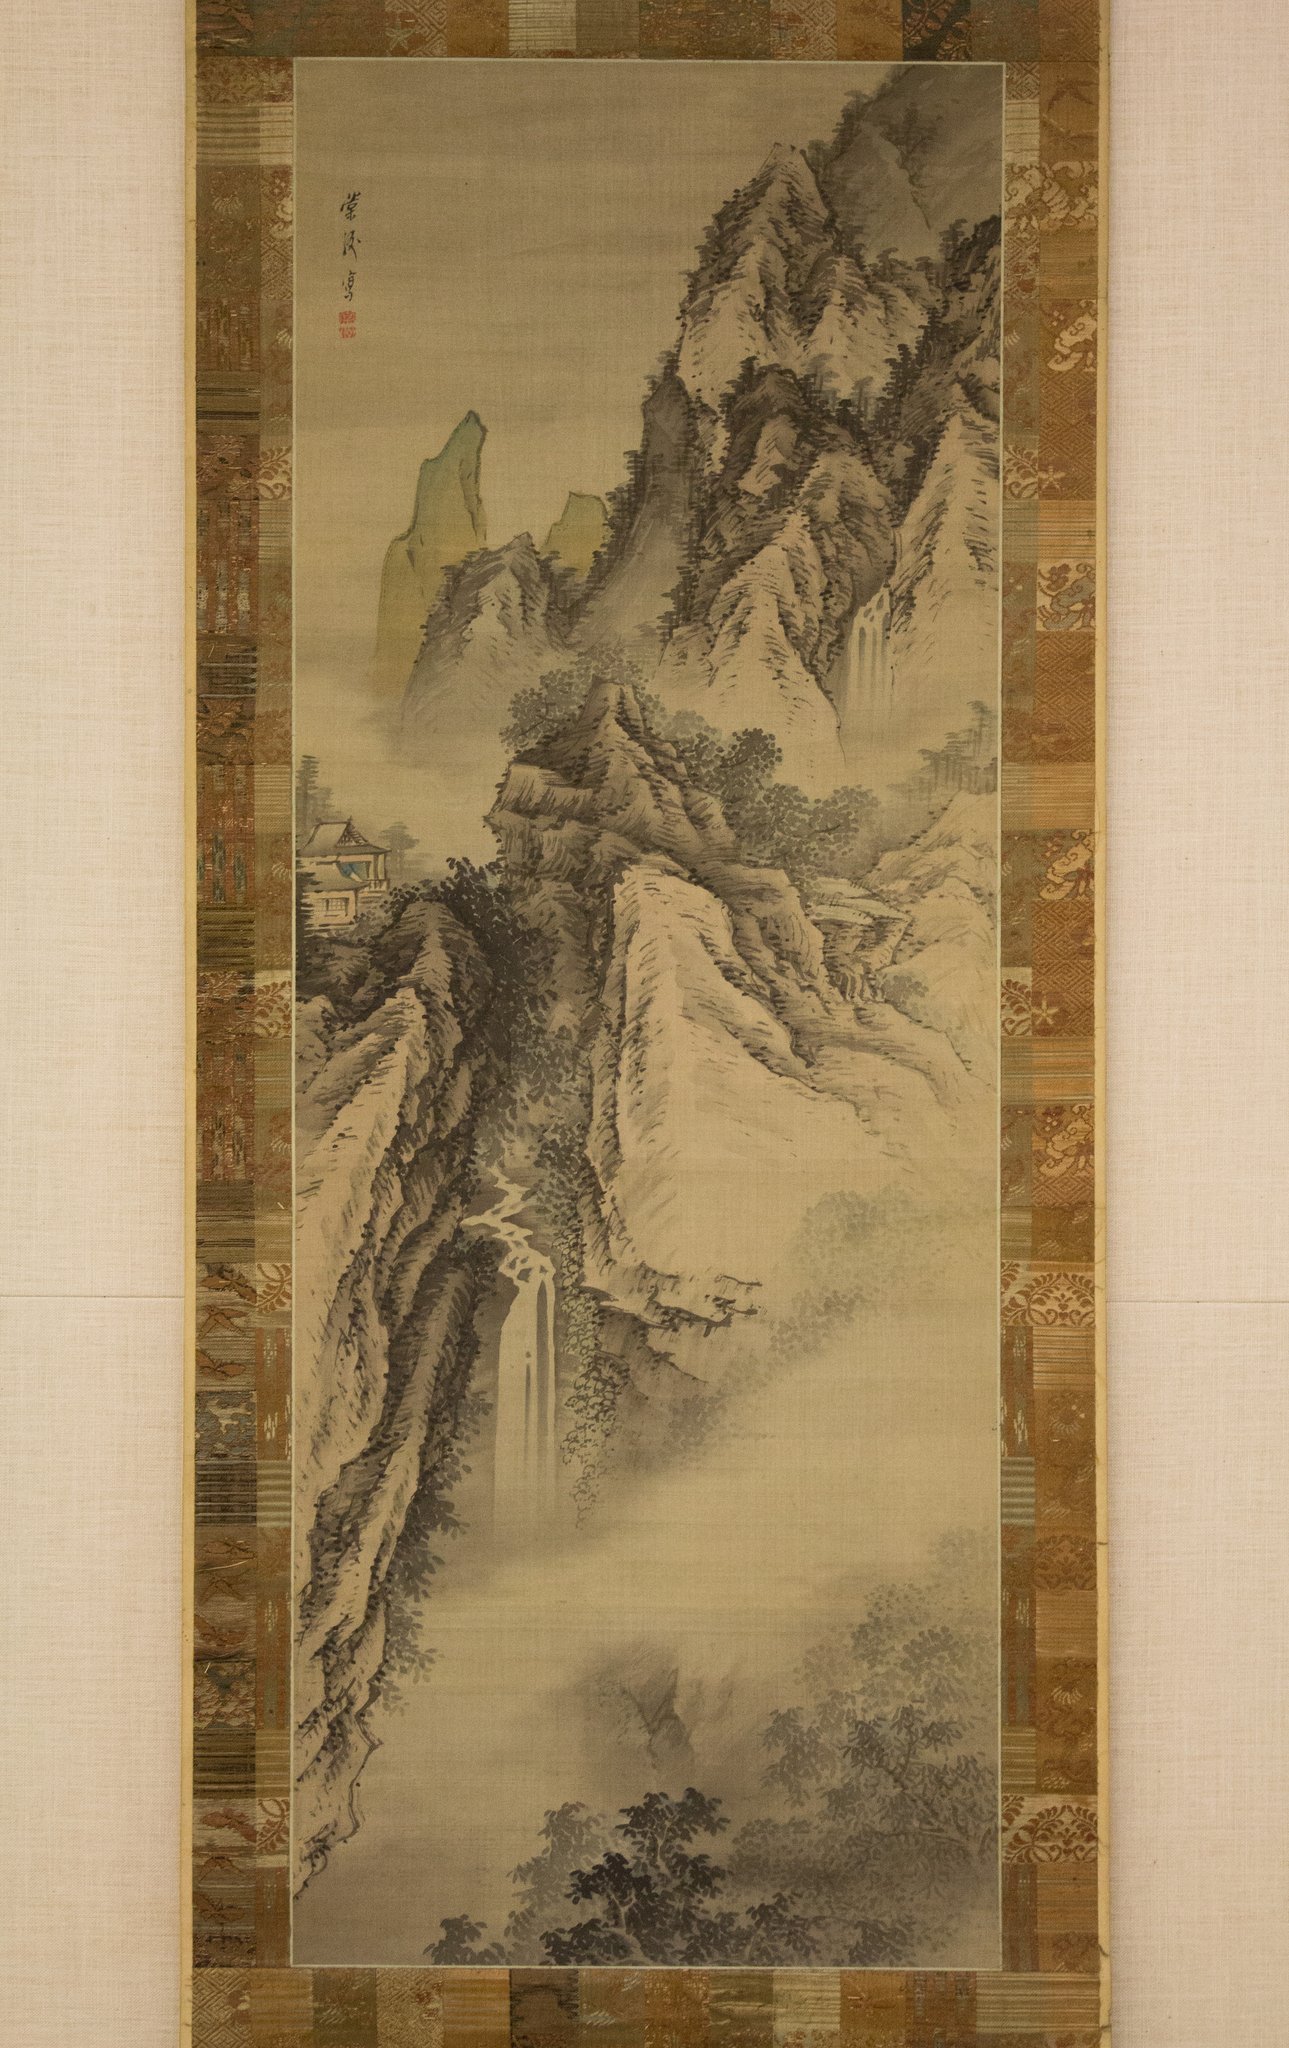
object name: hanging scroll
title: Mountain Scenery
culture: japanese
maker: senkaku toshu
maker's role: artist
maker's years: 1804-1871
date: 1801-1900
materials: ink, silk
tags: waterfalls,mountains,landscapes